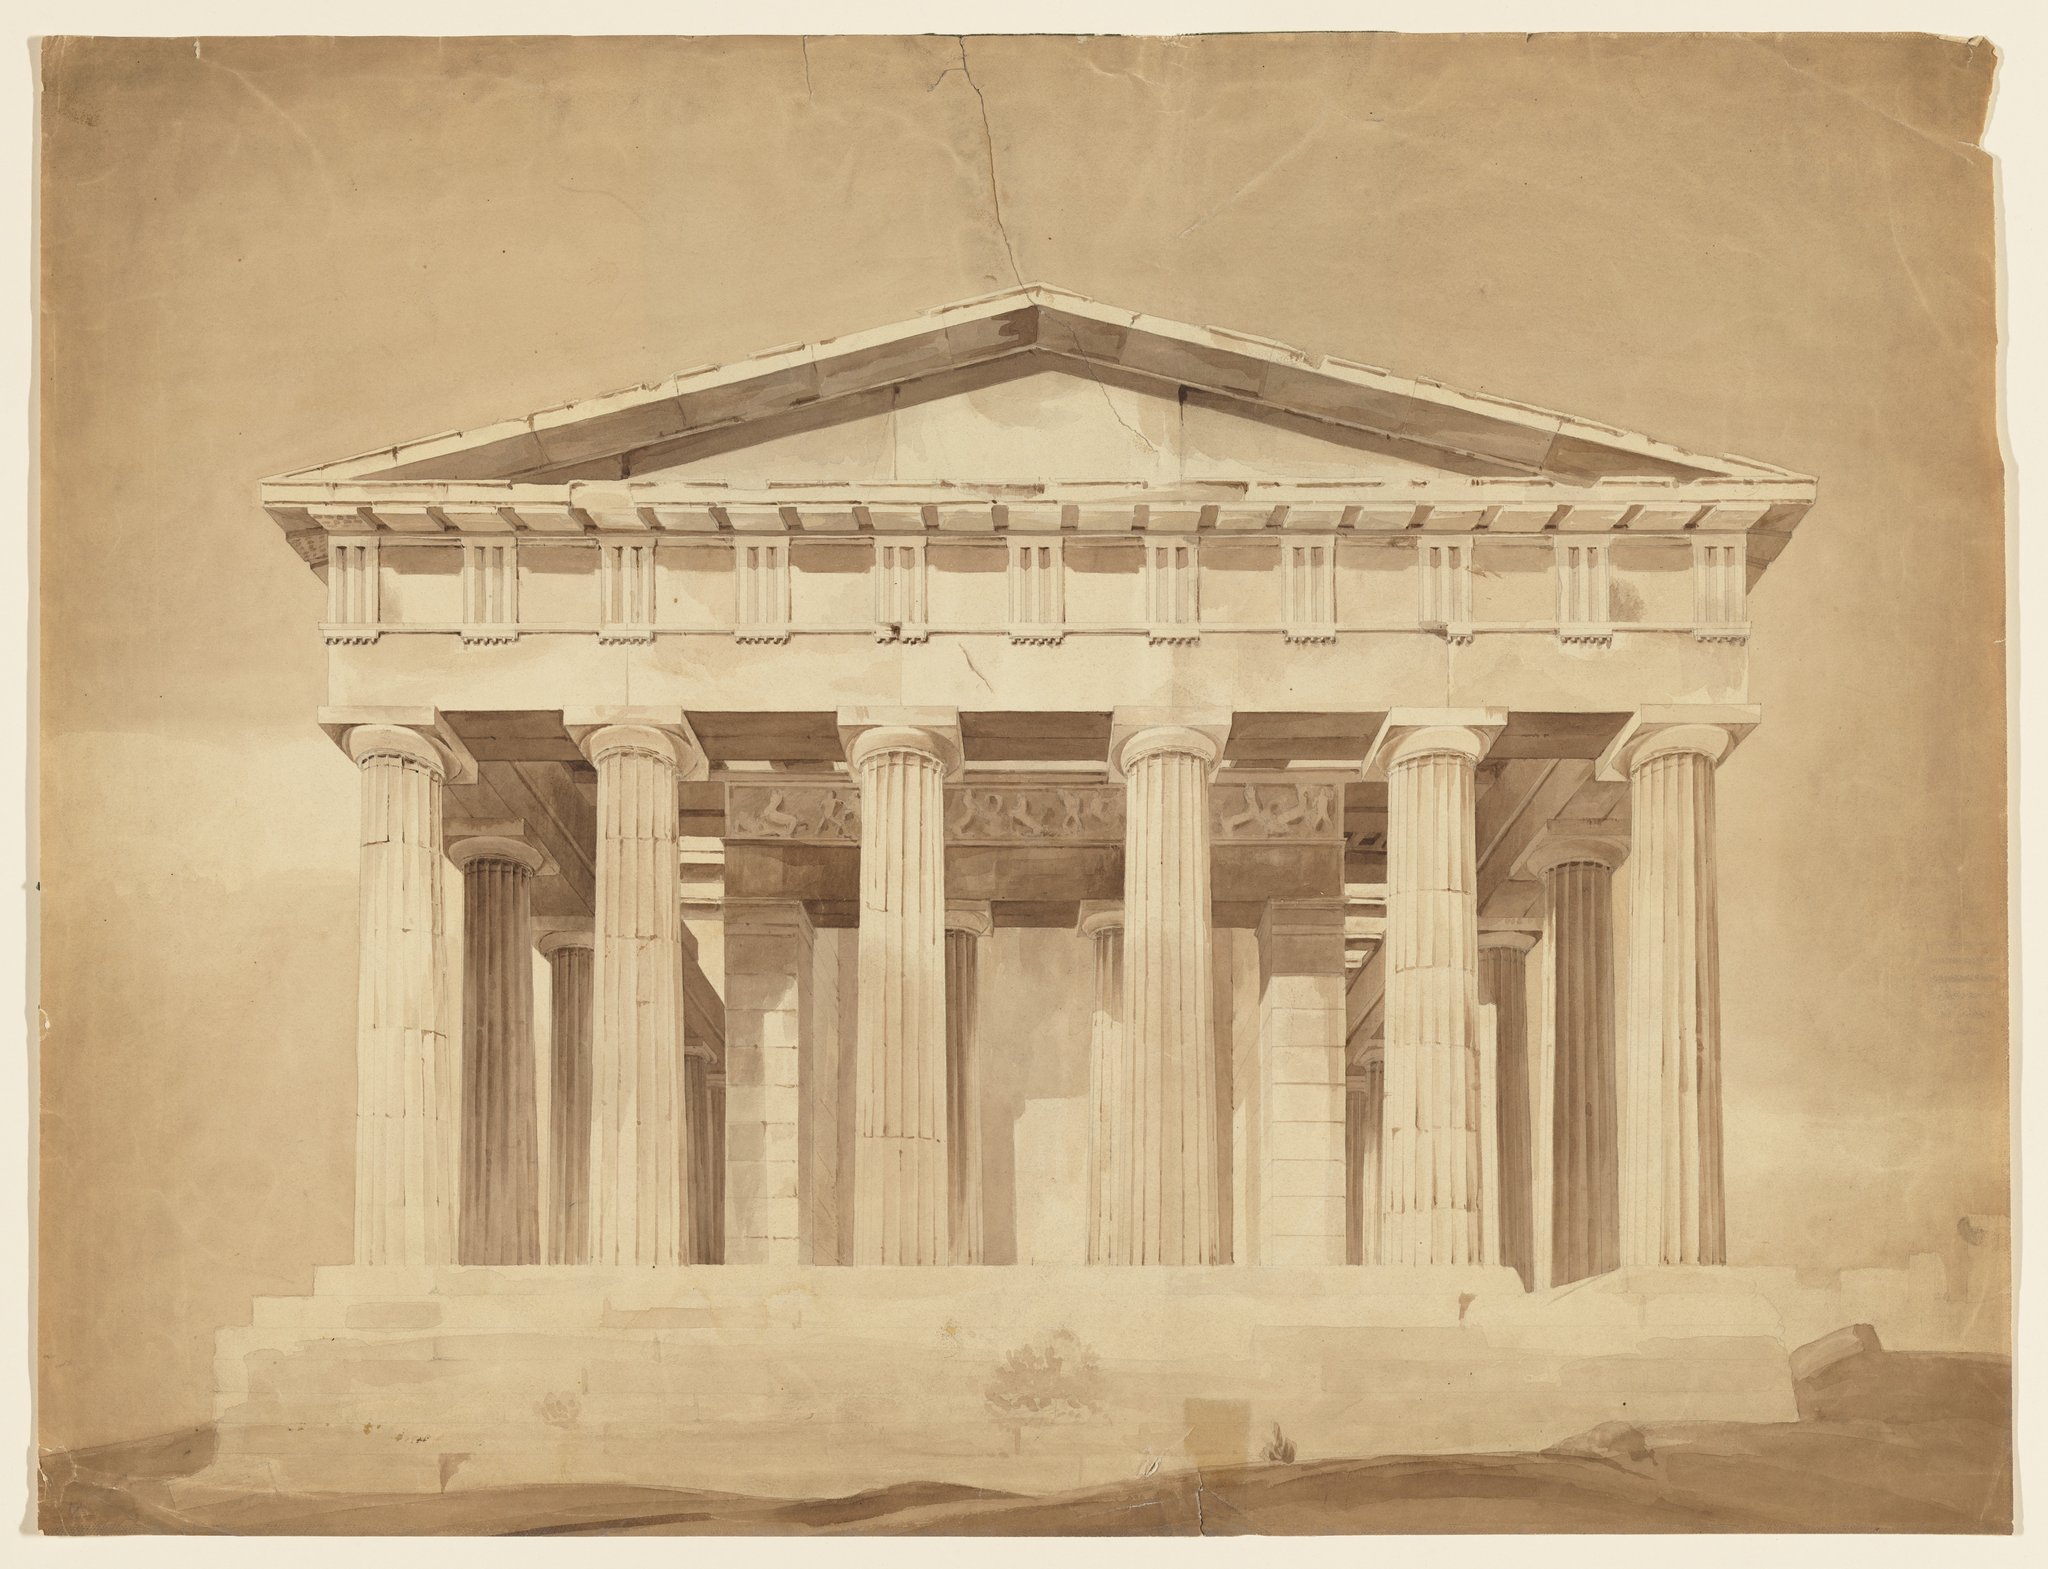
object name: ornament architecture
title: View of the Parthenon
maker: anonymous, british, 19th century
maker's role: artist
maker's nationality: british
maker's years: 1800-1900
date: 1801-1900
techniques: brush, wash